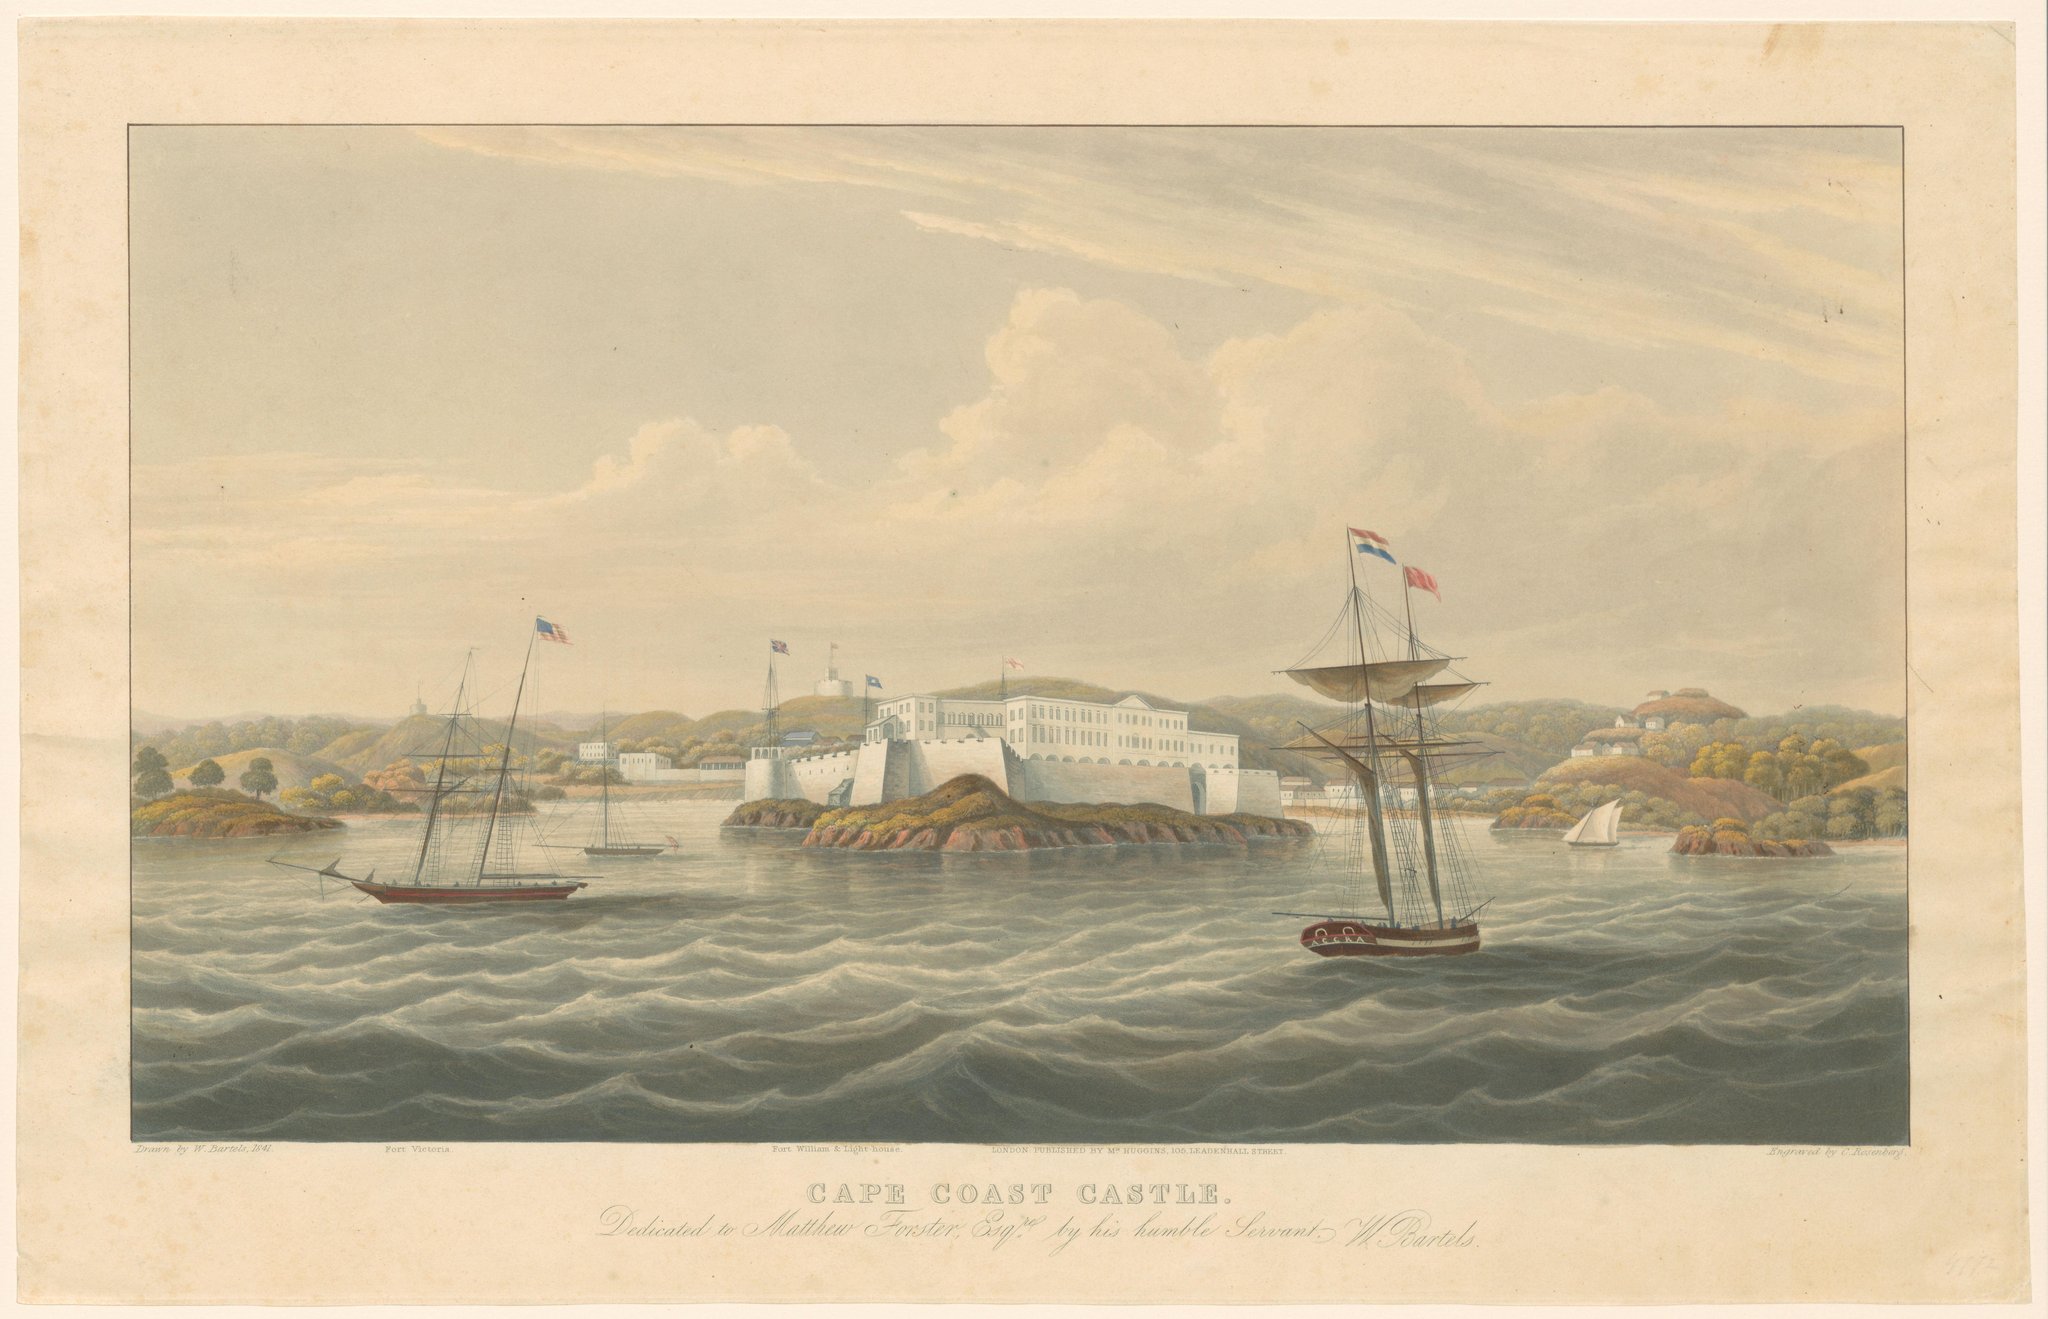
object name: print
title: Cape Coast Castle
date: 1841-1845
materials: paper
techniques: etching, hand coloring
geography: london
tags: slave-trade, fortress, imperialism, beach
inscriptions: collector's mark: Lugt 2228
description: In de ondermarge tekst in het Nederlands met plaatsaanduidingen.